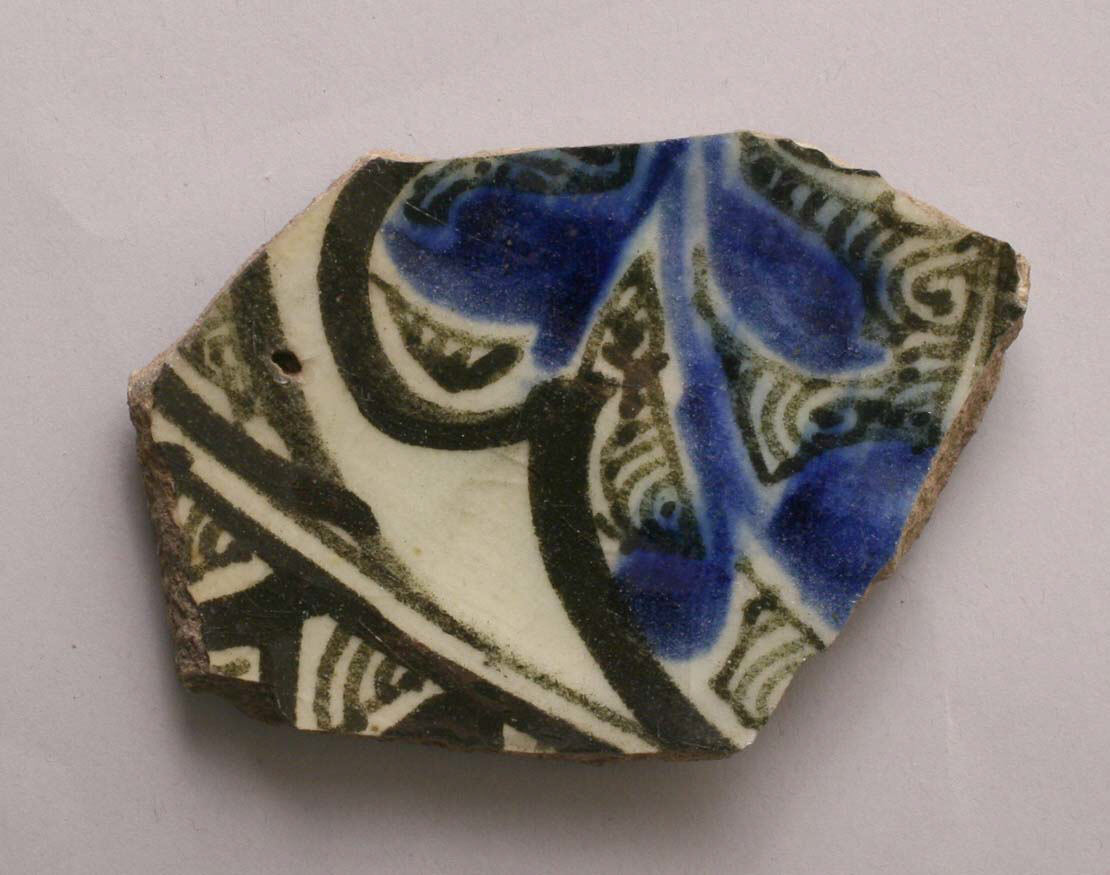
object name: fragment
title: Ceramic Fragment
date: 1301-1400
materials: glaze, stonepaste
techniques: painting, polychrome, underglaze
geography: syria